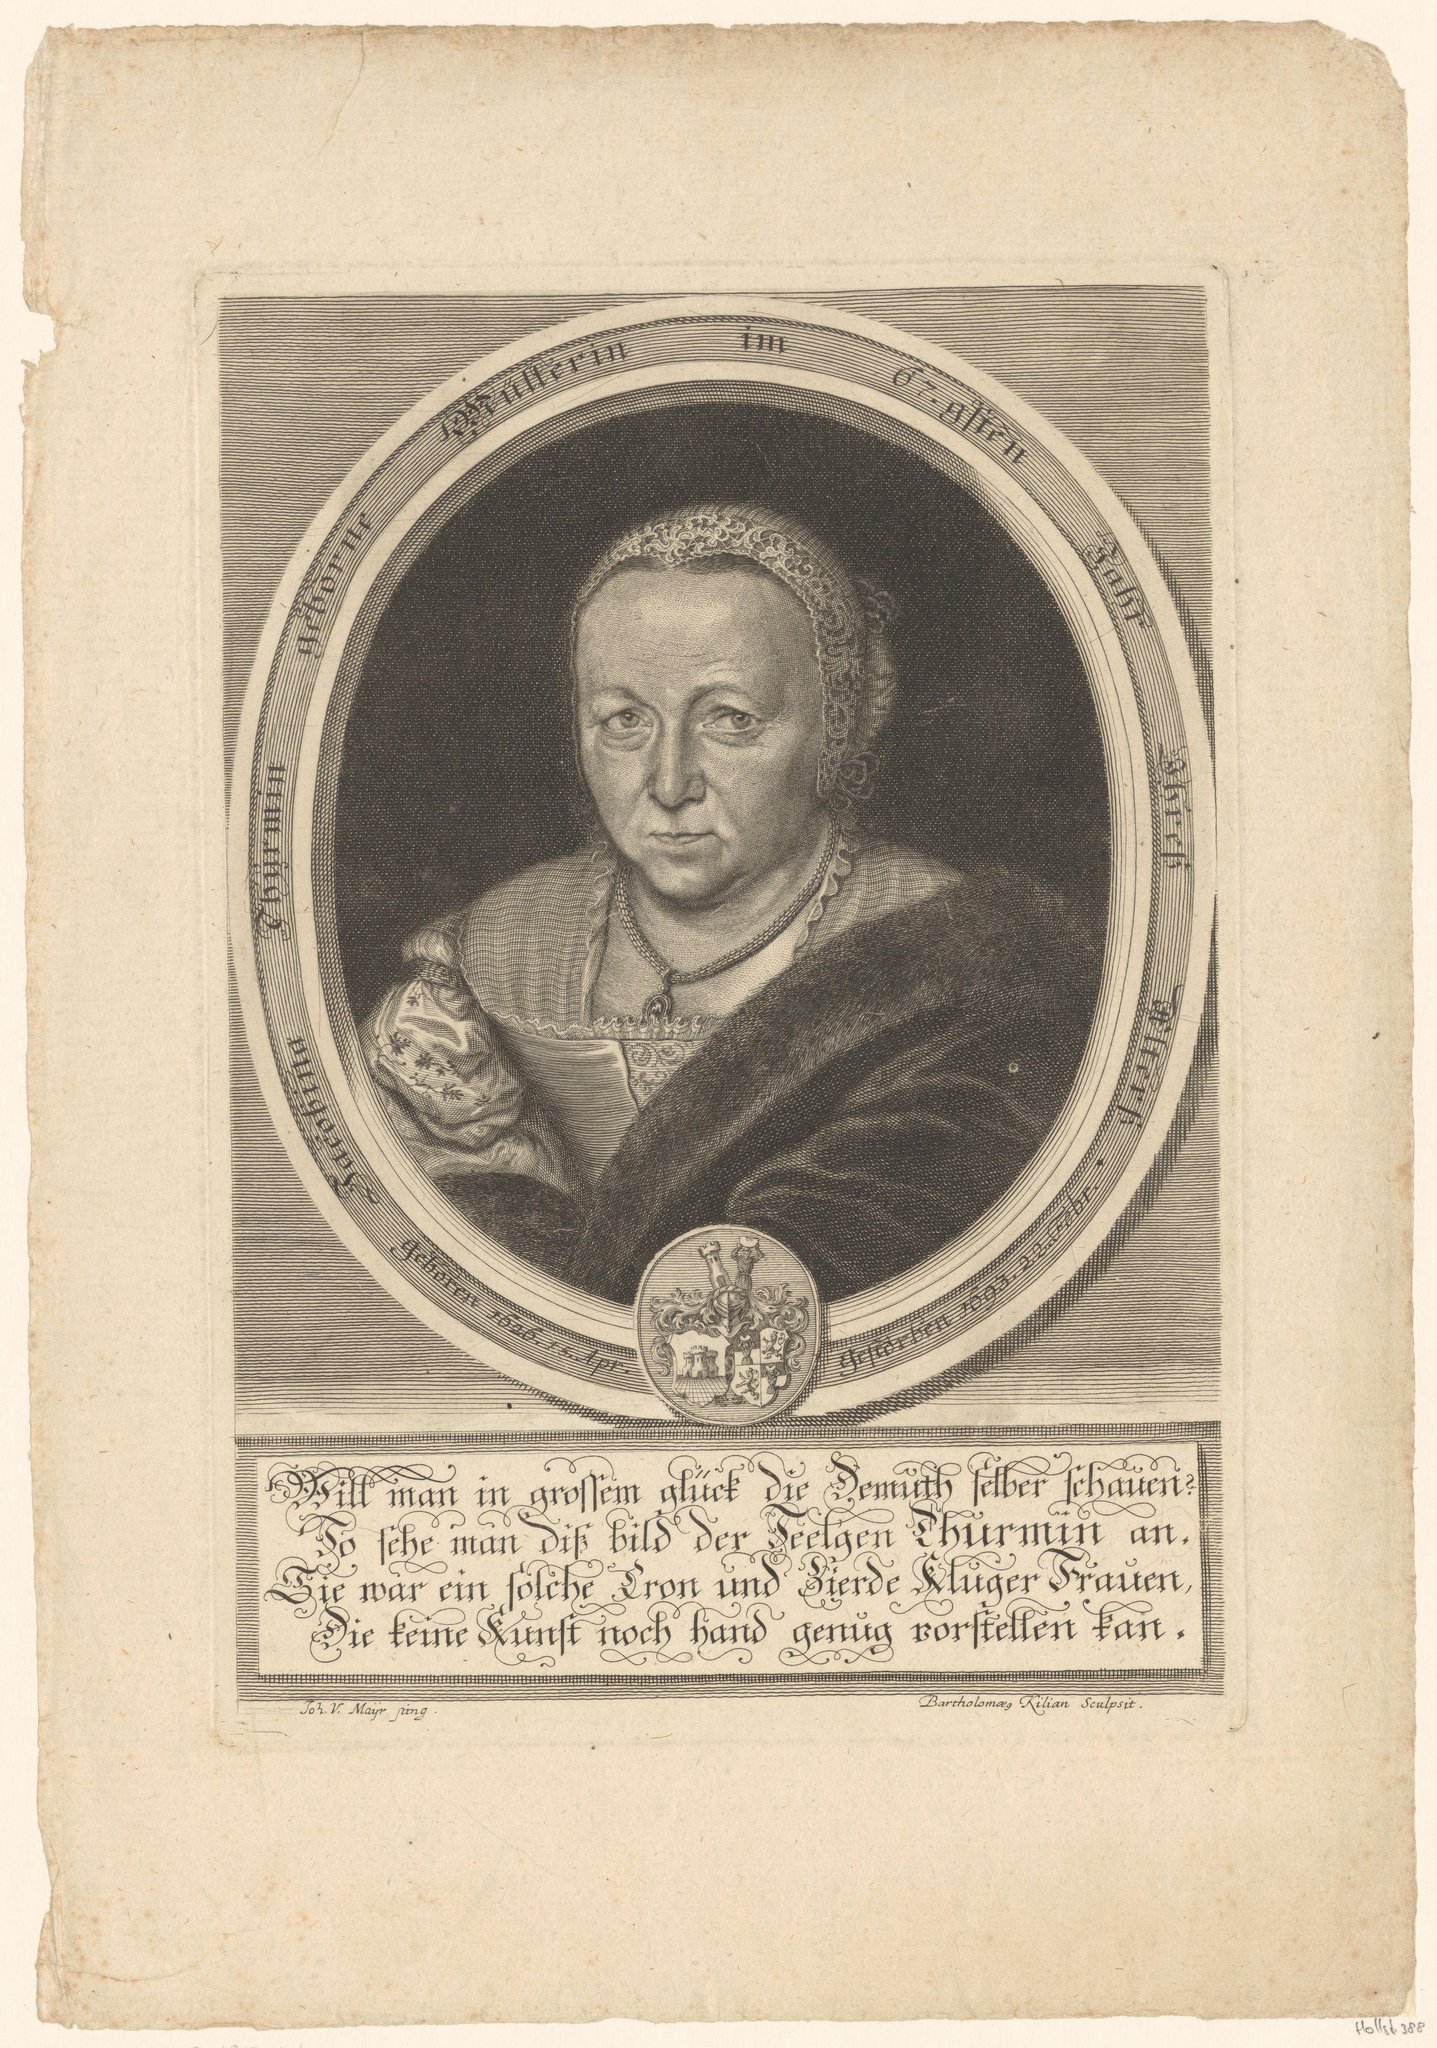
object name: print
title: Portret van Jacobina Thurm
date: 1693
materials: paper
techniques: engraving, etching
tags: historical persons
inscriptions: collector's mark: Lugt 2228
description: Tekst in het Duits in de omlijsting en in de marge.